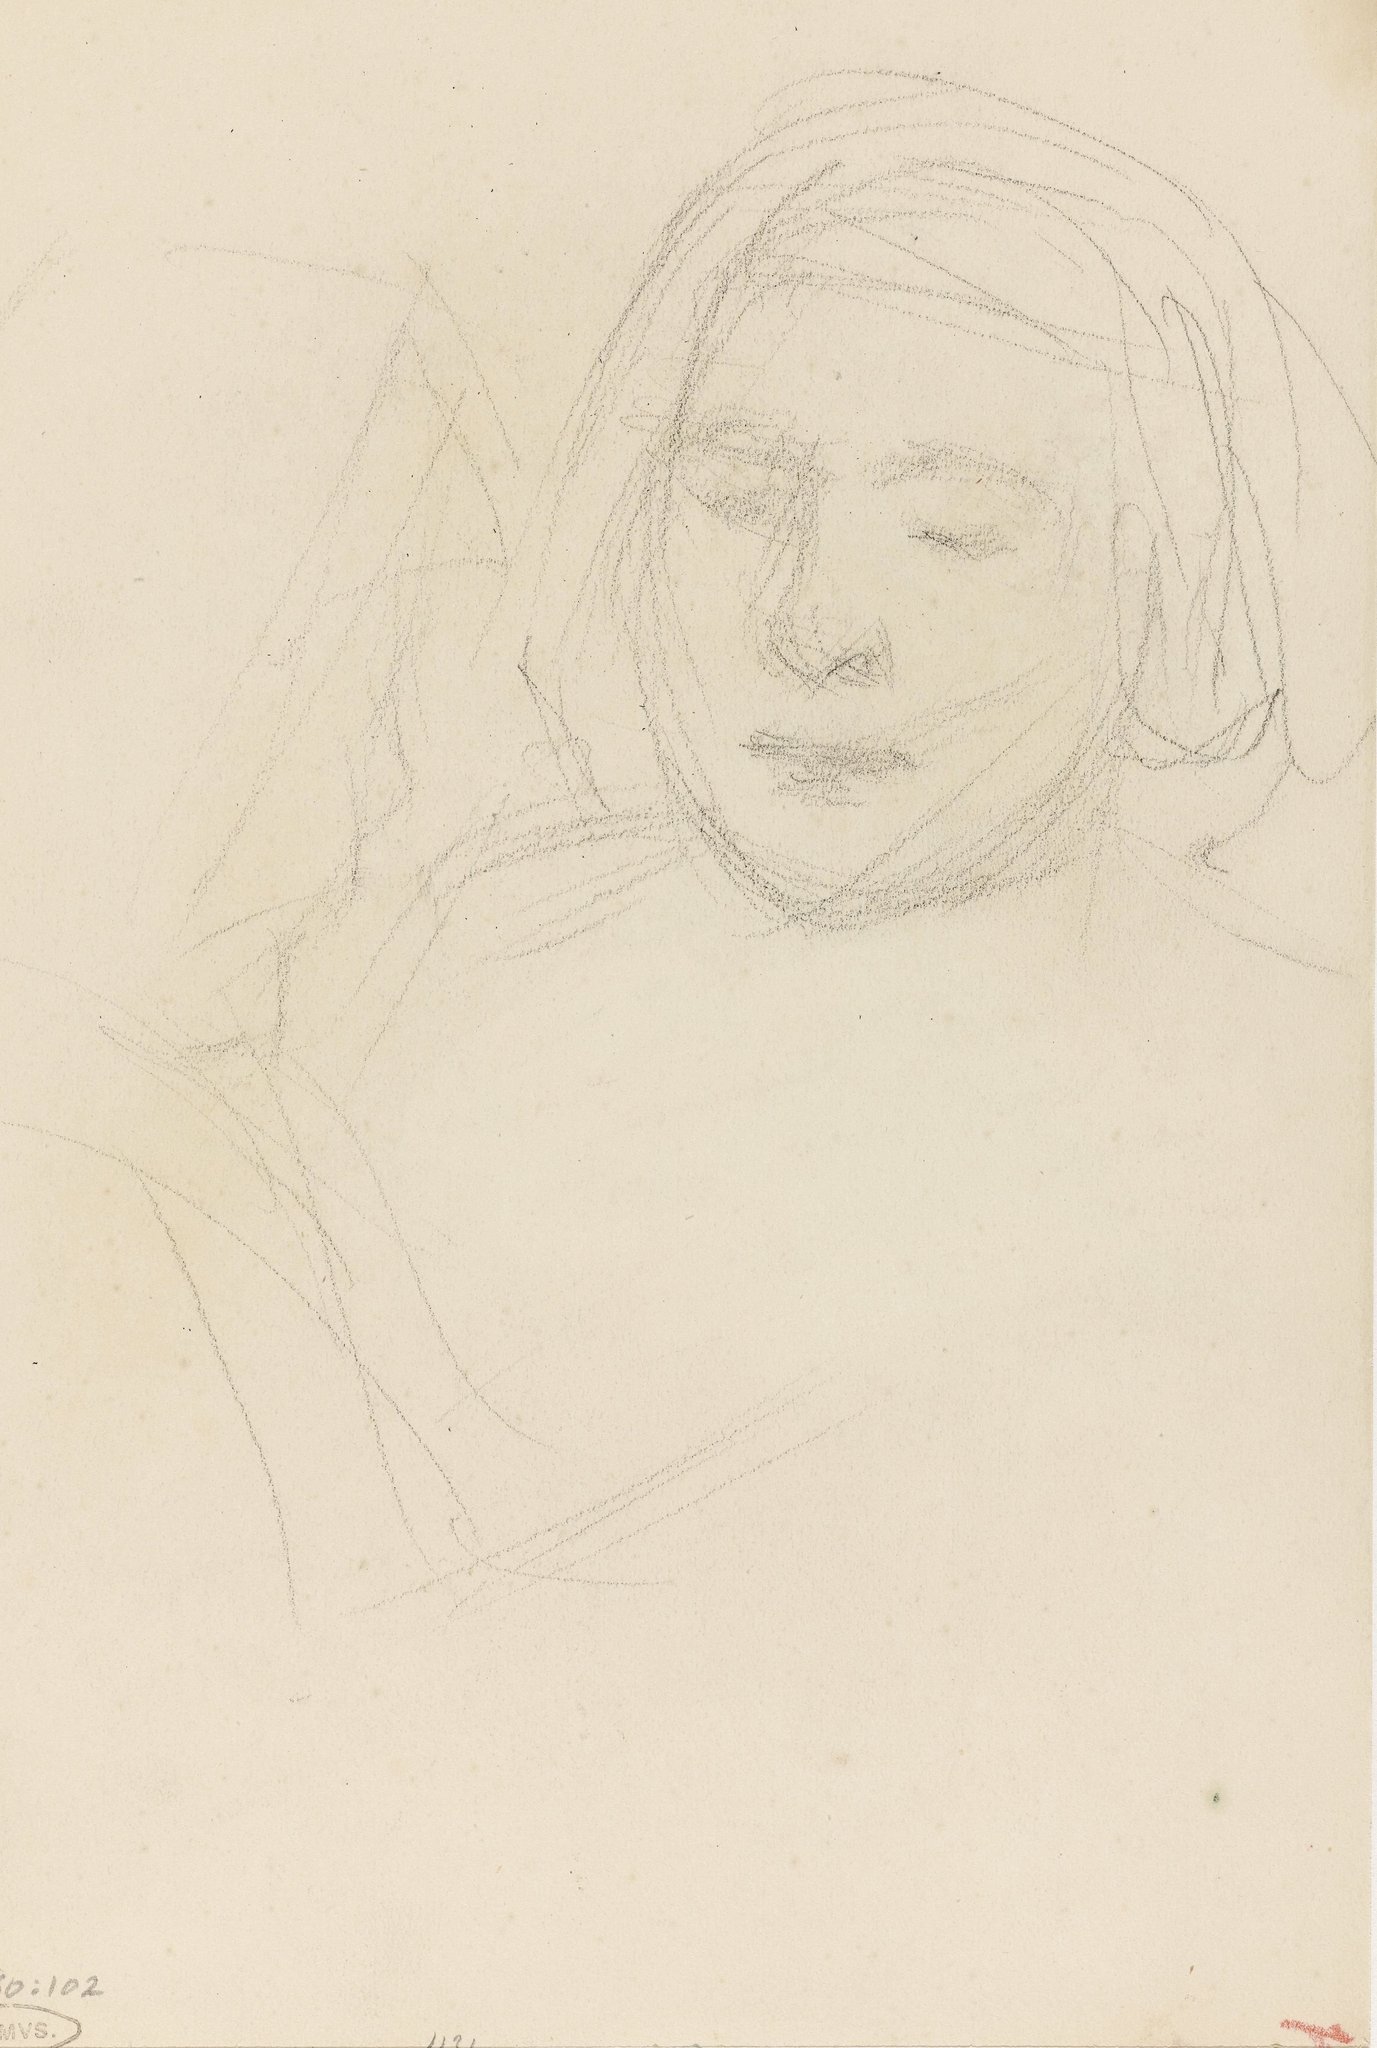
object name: drawing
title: Schets van twee meisjes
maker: jozef israëls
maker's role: draughtsman, painter, print maker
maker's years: 1824-1911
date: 1834-1911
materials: chalk, paper